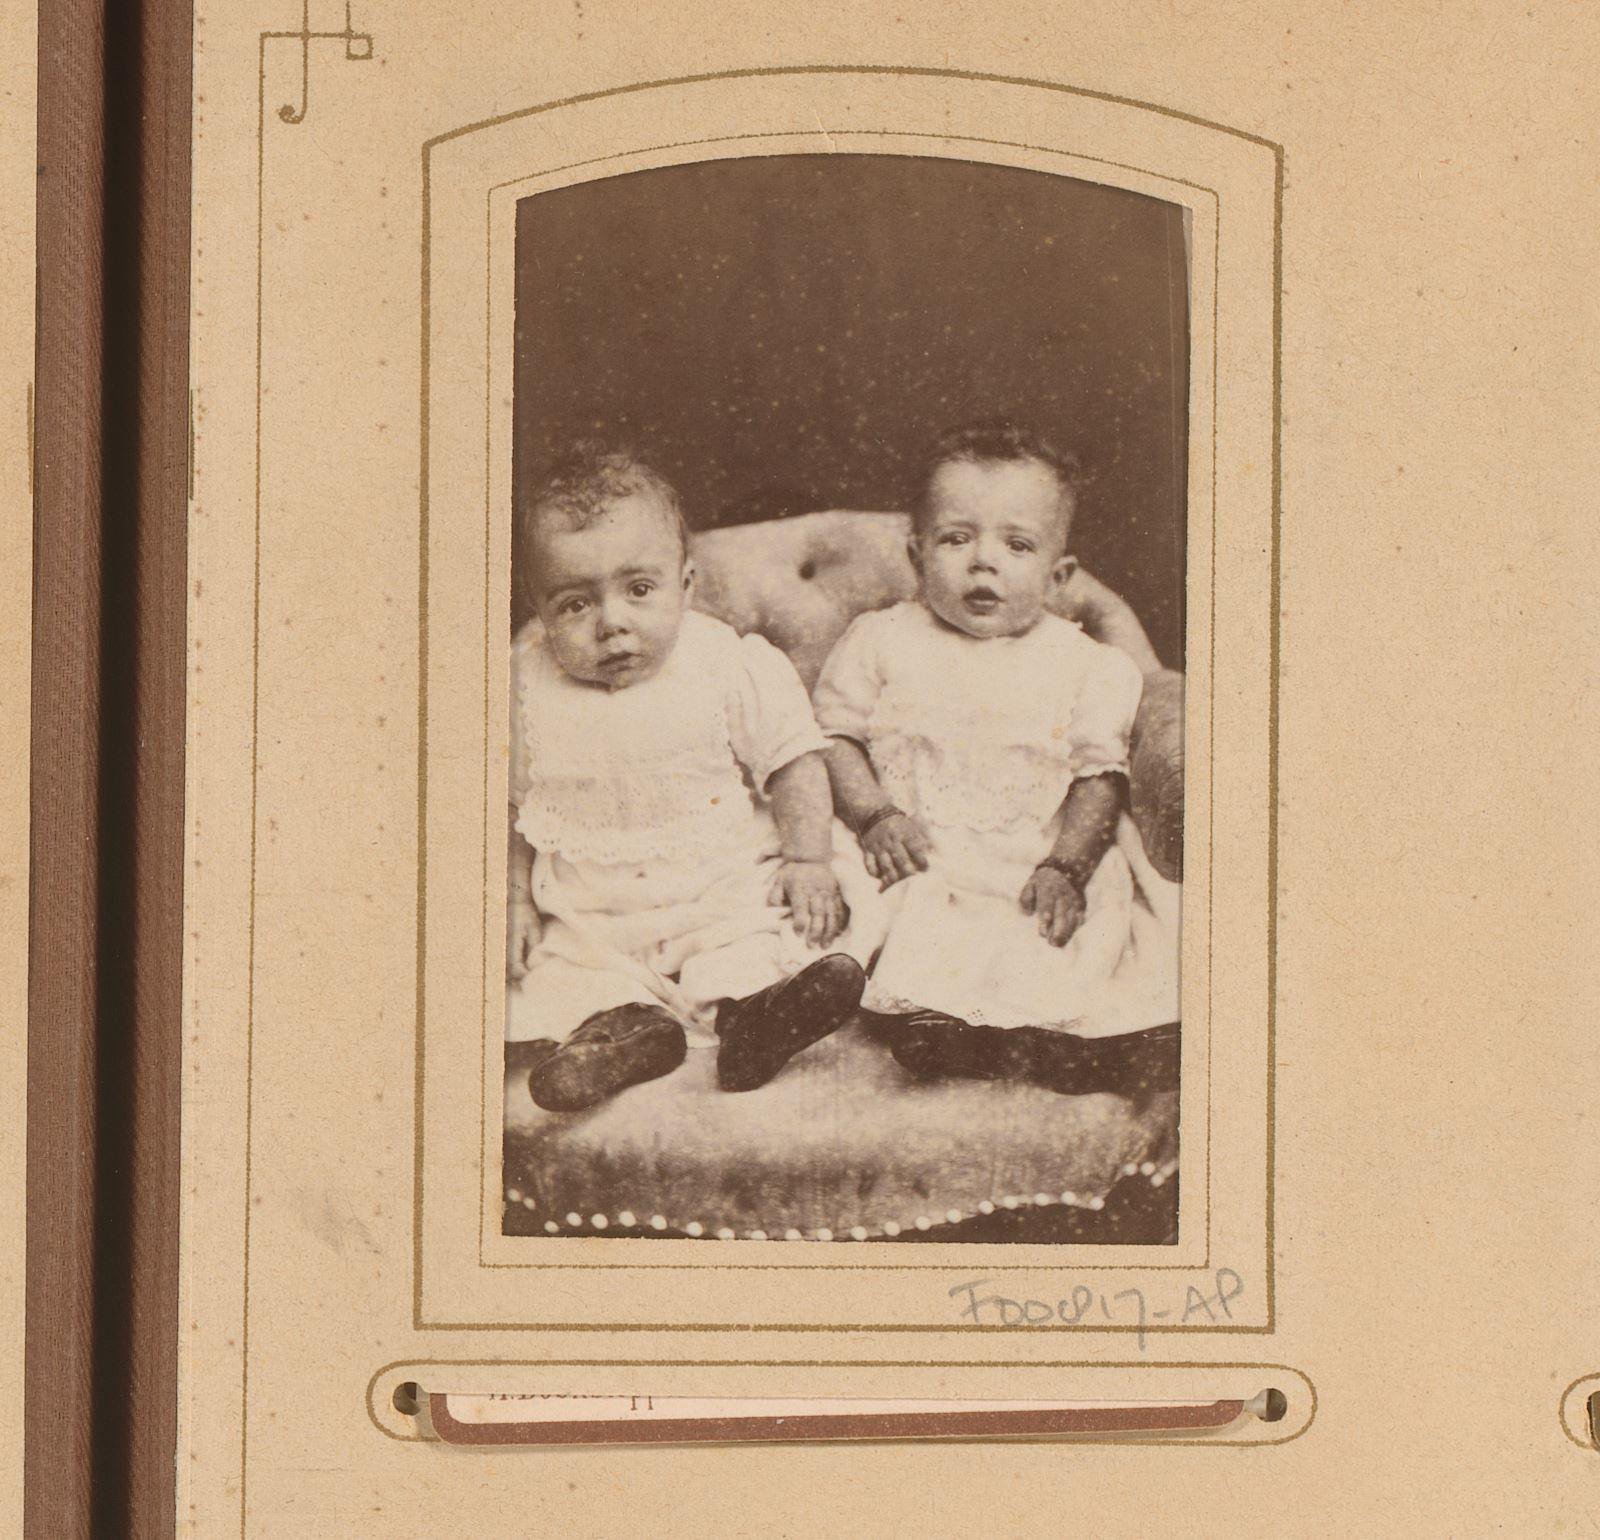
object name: photograph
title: Portret van twee kleuters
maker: hendrik boonstoppel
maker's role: fotograaf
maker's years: 1854-1924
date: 1880-1901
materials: cardboard, photographic support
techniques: albumen print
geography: dordrecht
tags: child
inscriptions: inscription: ‘H. Boonstoppel/ Dordrecht’